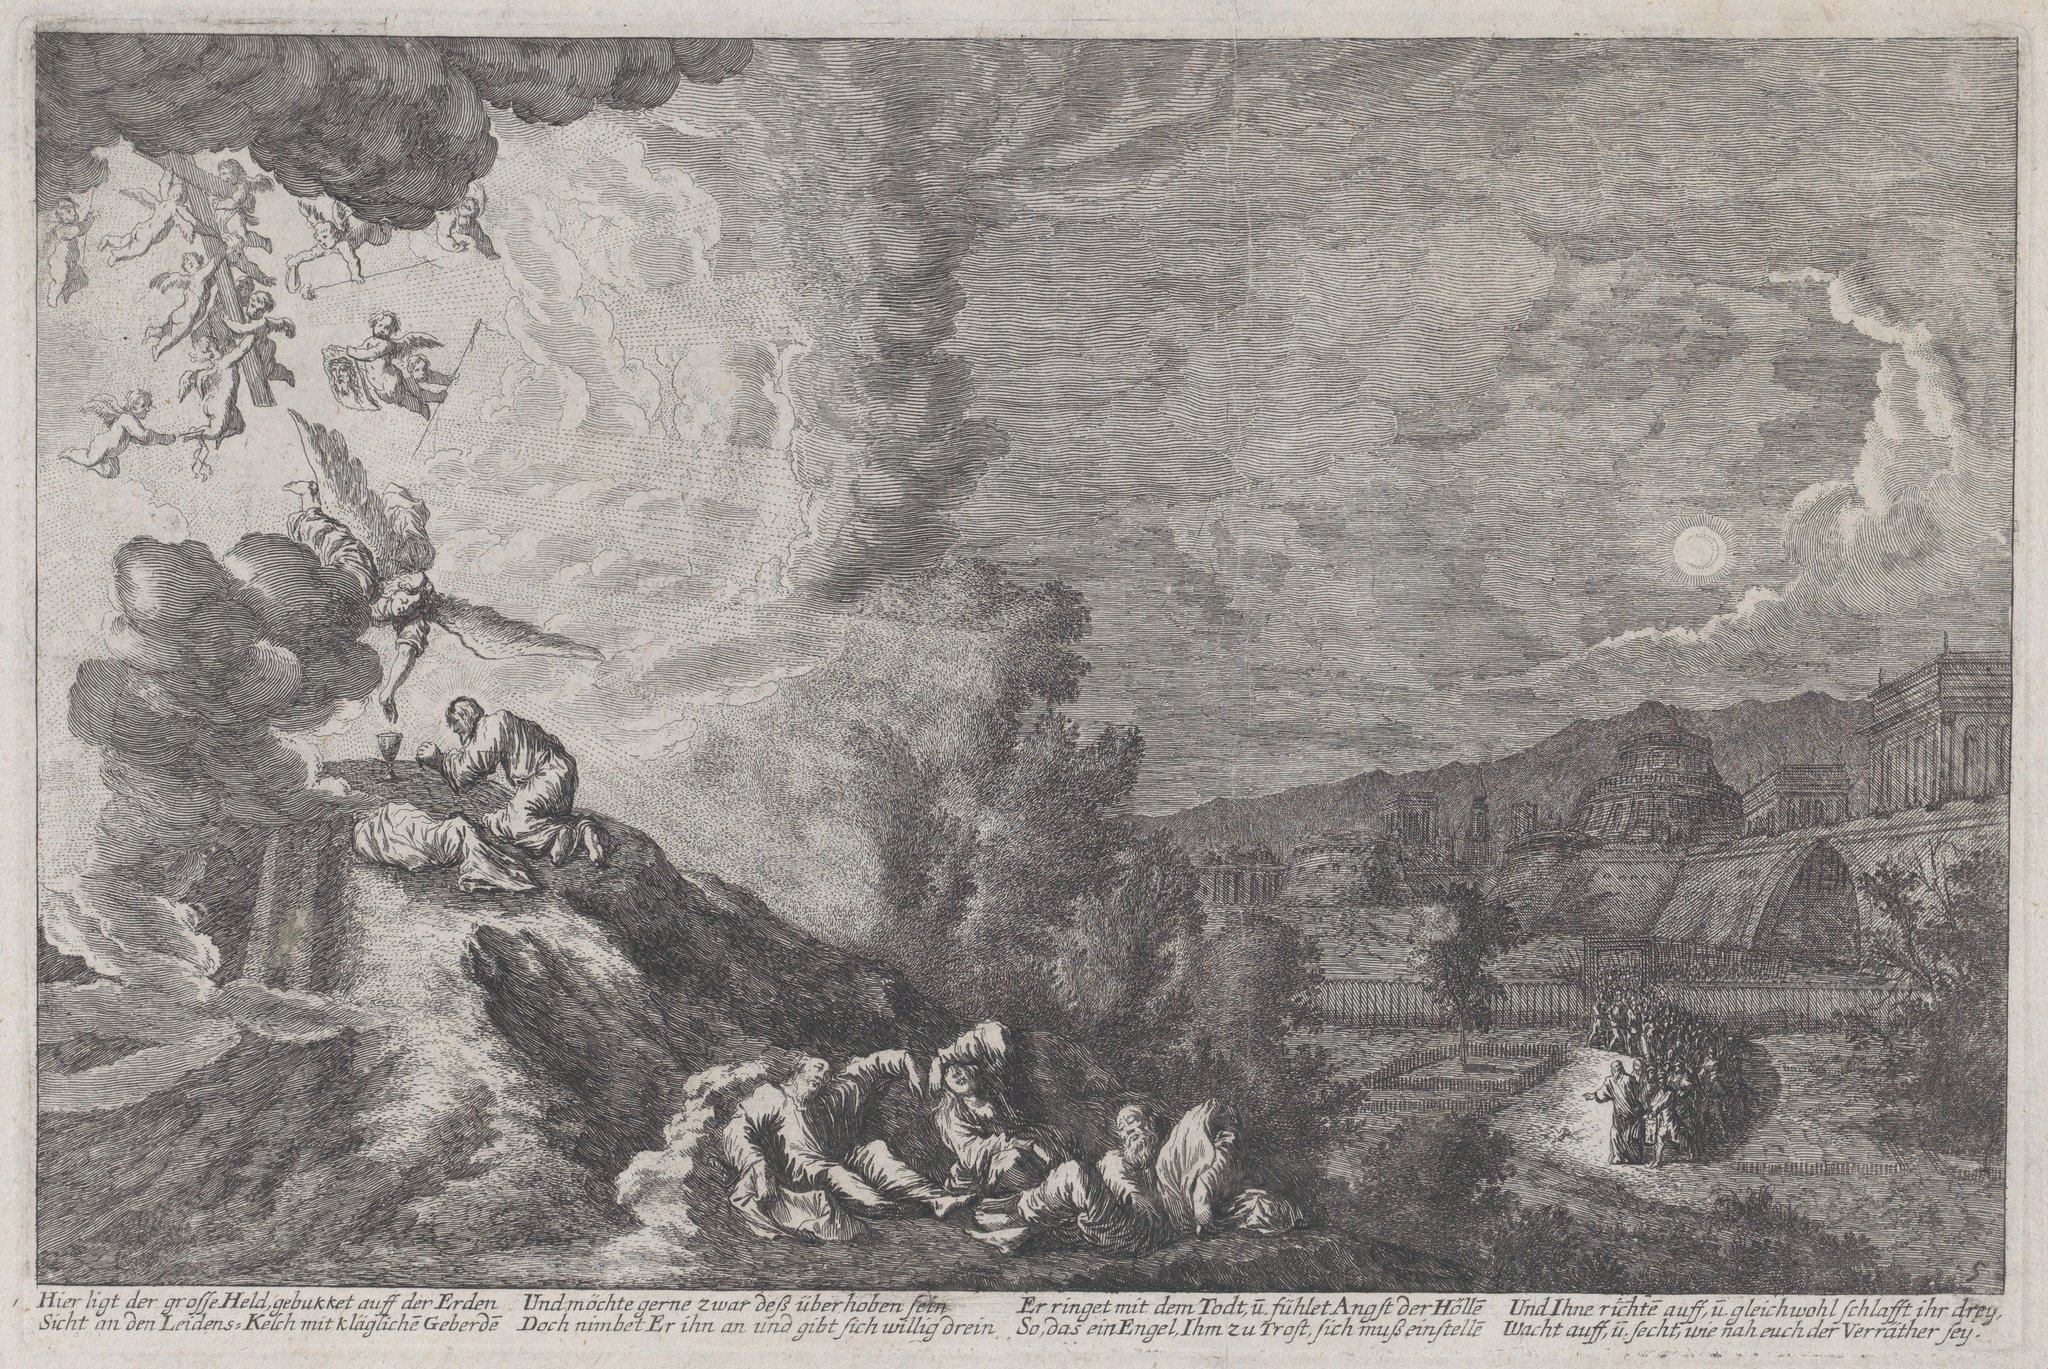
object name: print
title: The Agony in the Garden, from 'Iconographia'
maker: melchior küsel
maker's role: artist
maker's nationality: german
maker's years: 1626-1683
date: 1670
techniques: etching